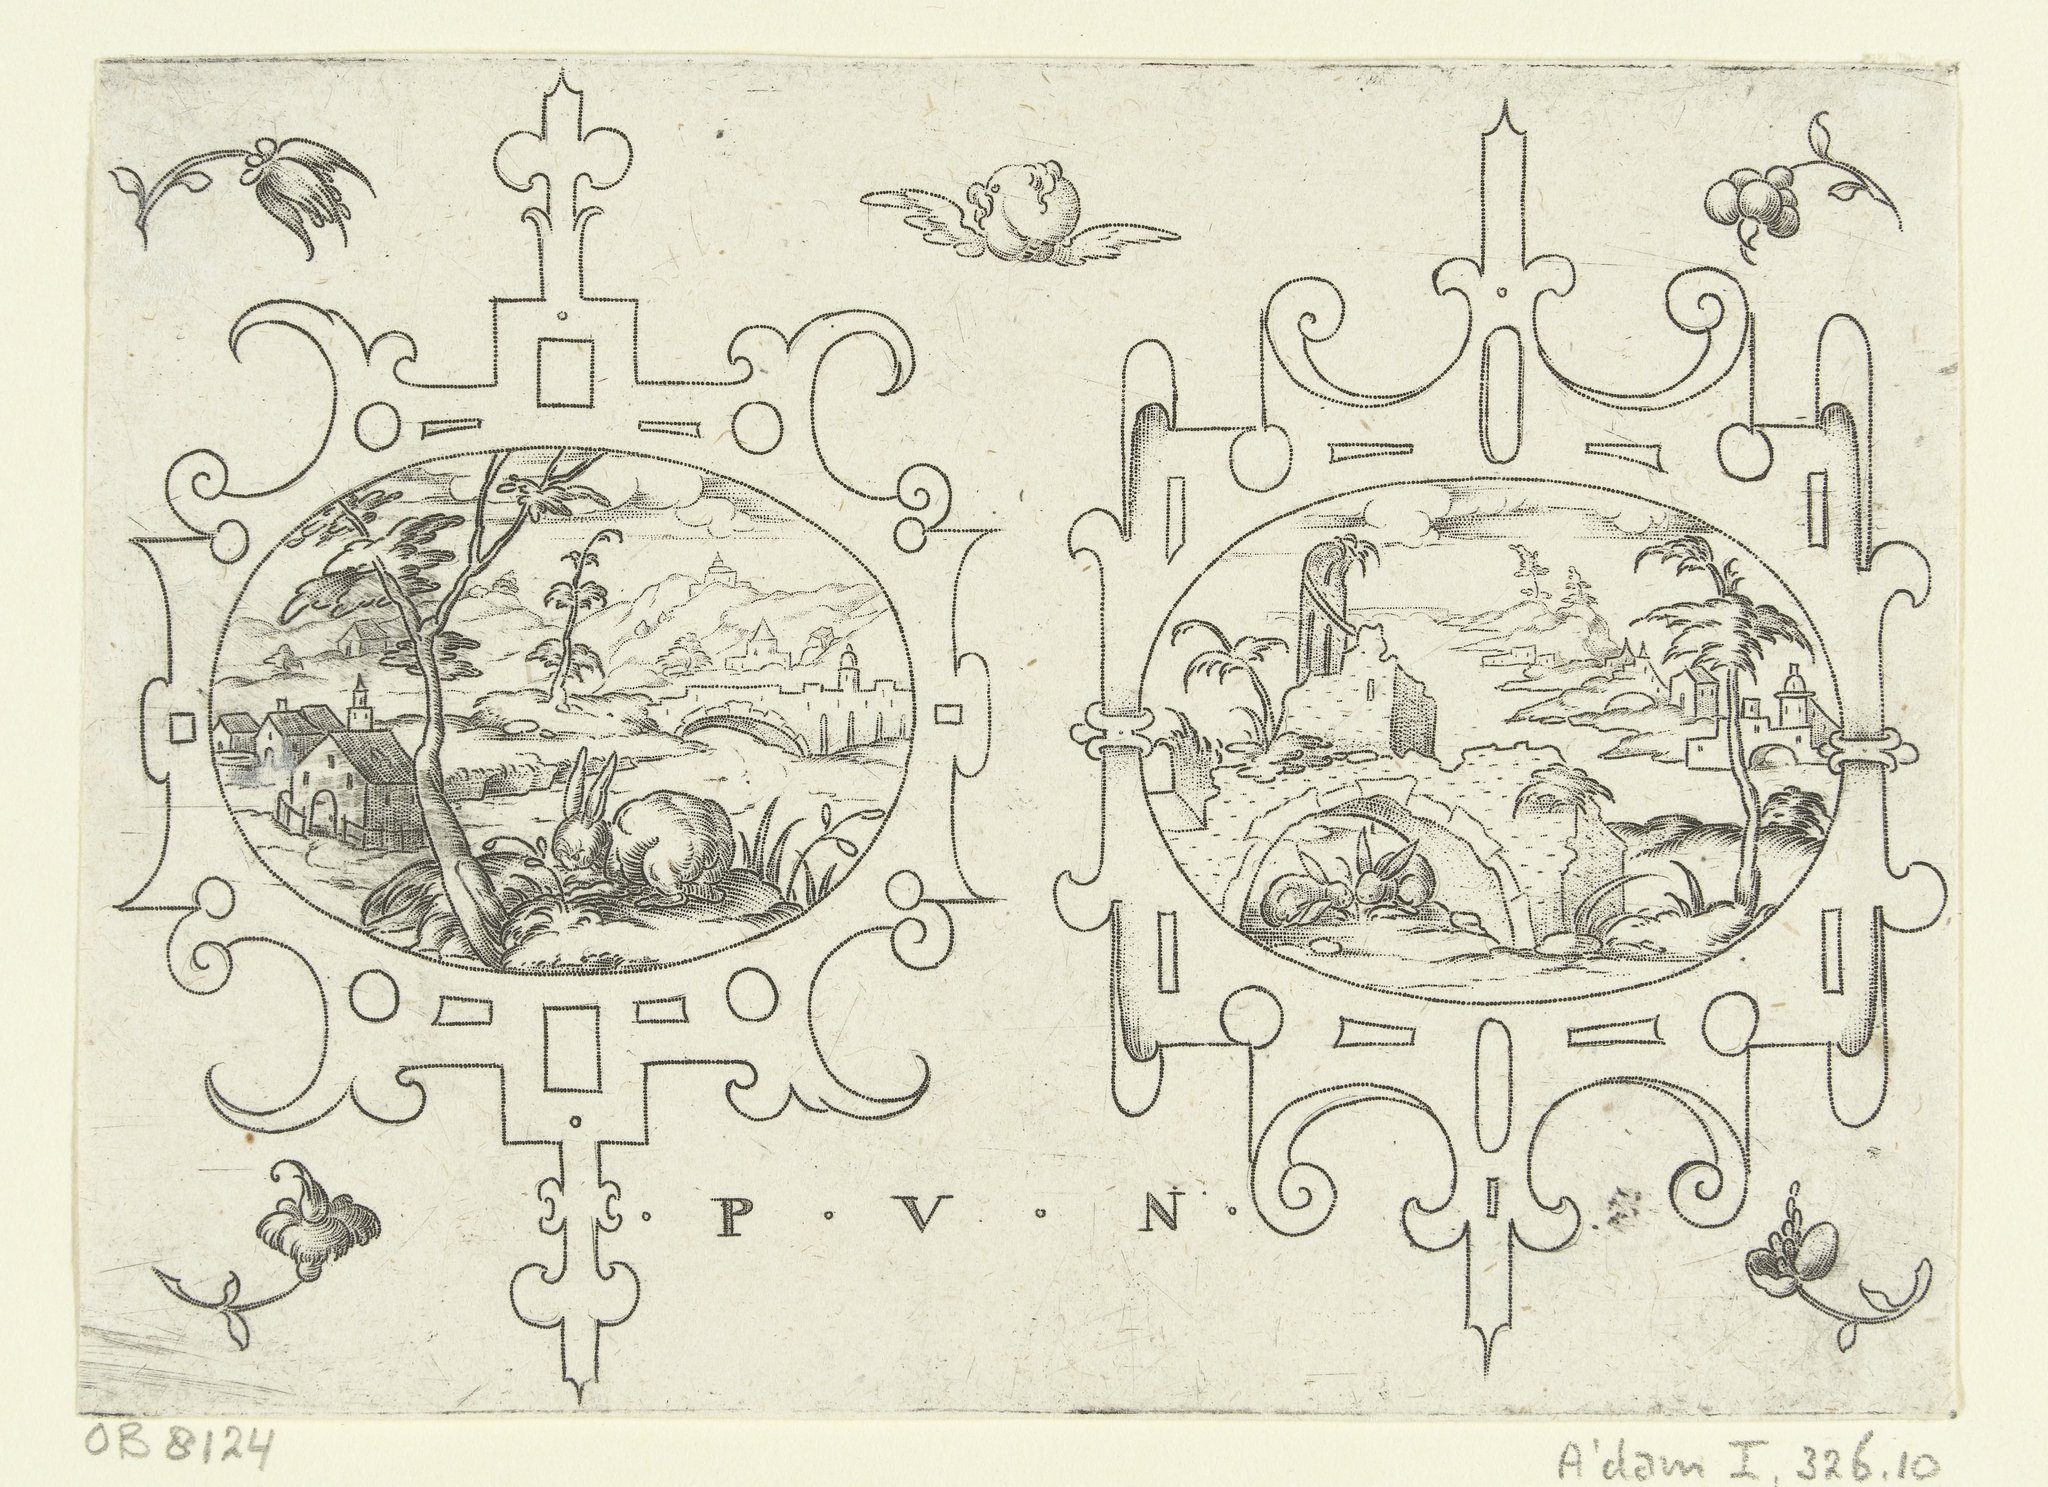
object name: ornament print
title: Ovale cartouches in een omlijsting van krulwerk met dieren in landschappen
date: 1600-1699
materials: paper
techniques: engraving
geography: germany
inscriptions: collector's mark: Lugt 240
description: Ovaal links met een konijn, ovaal rechts met konijntjes onder een ruïne. Uit serie van 12 bladen.